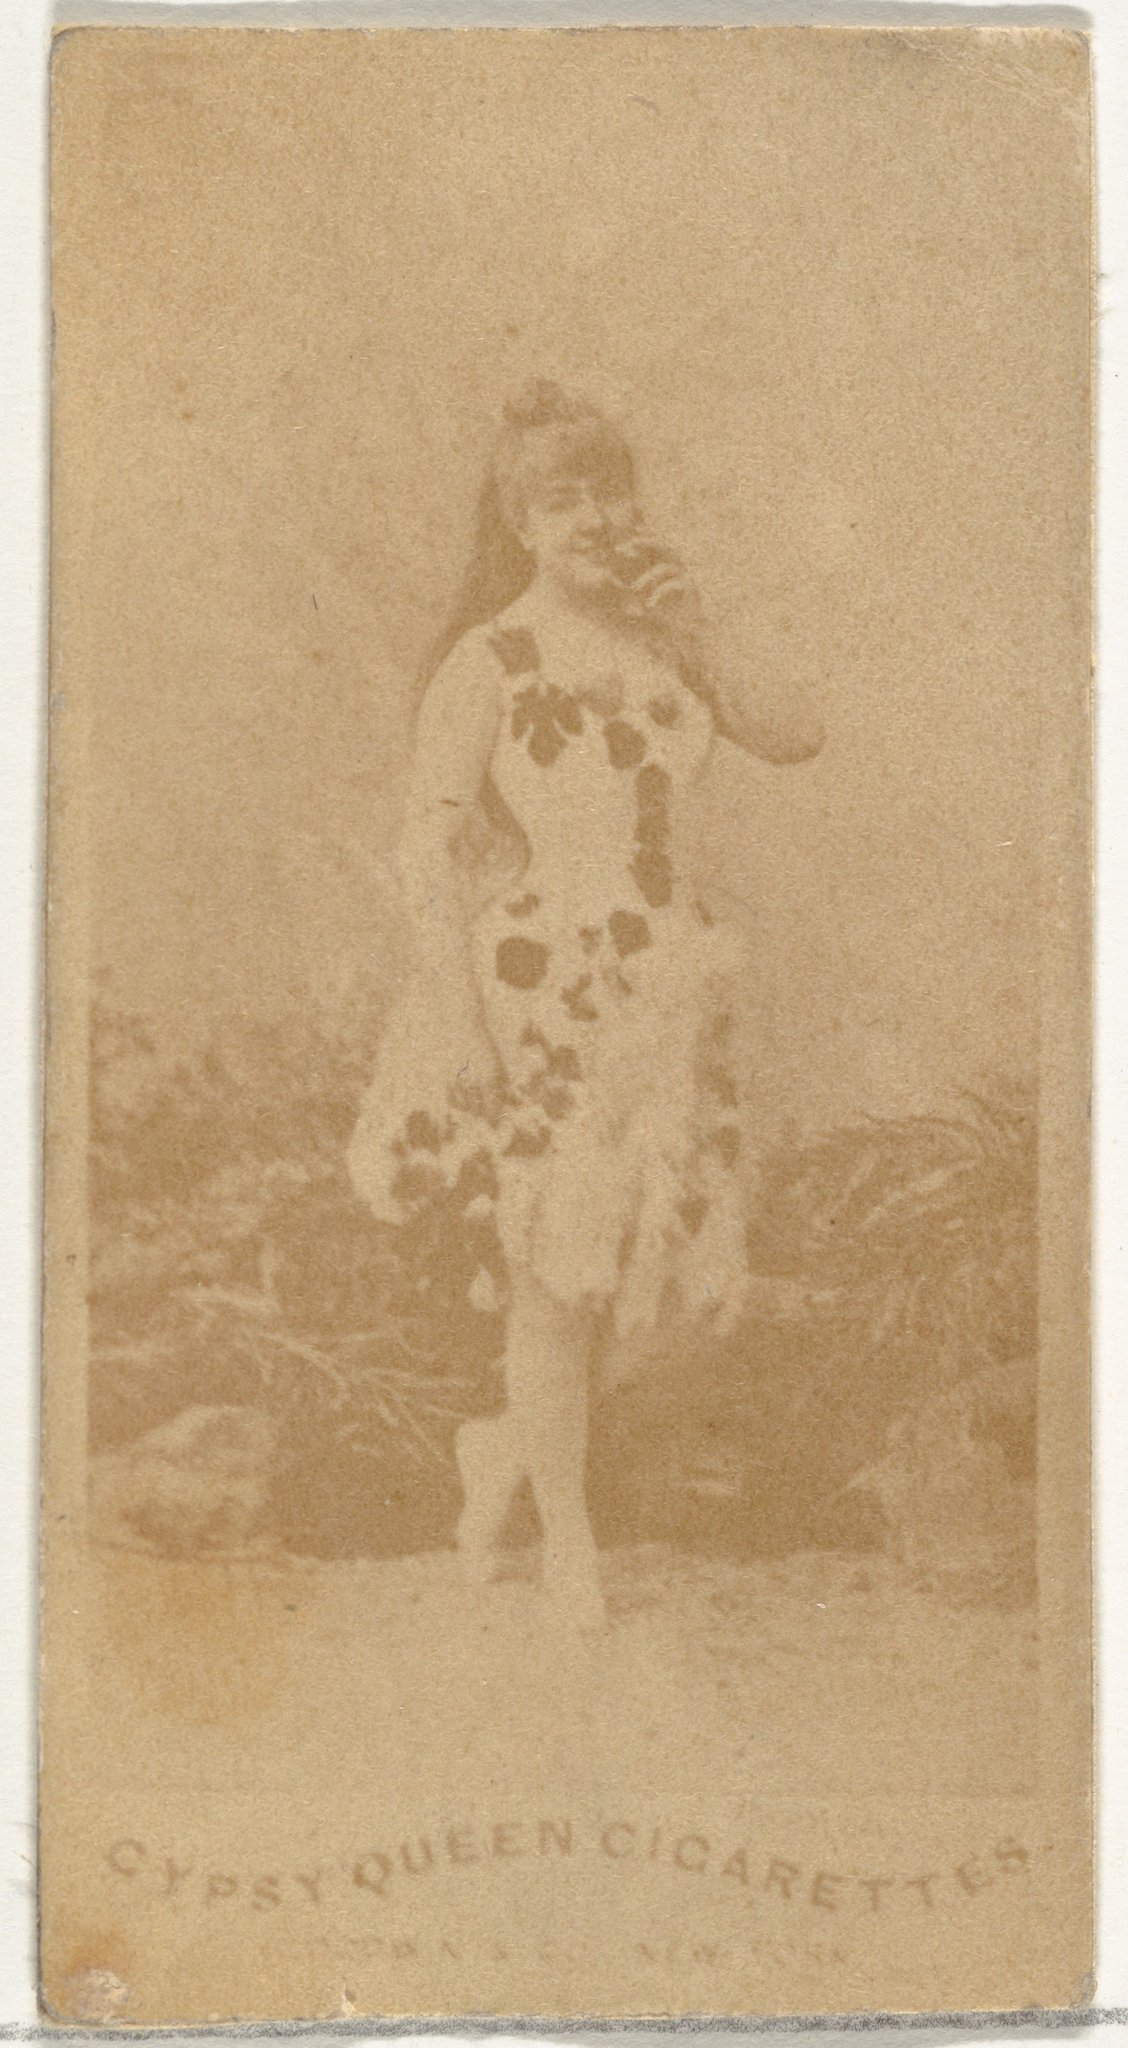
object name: photograph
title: From the Actors and Actresses series (N171) for Gypsy Queen Cigarettes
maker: goodwin & company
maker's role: publisher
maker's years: 1850-1950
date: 1886-1890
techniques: albumen silver print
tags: portraits,women